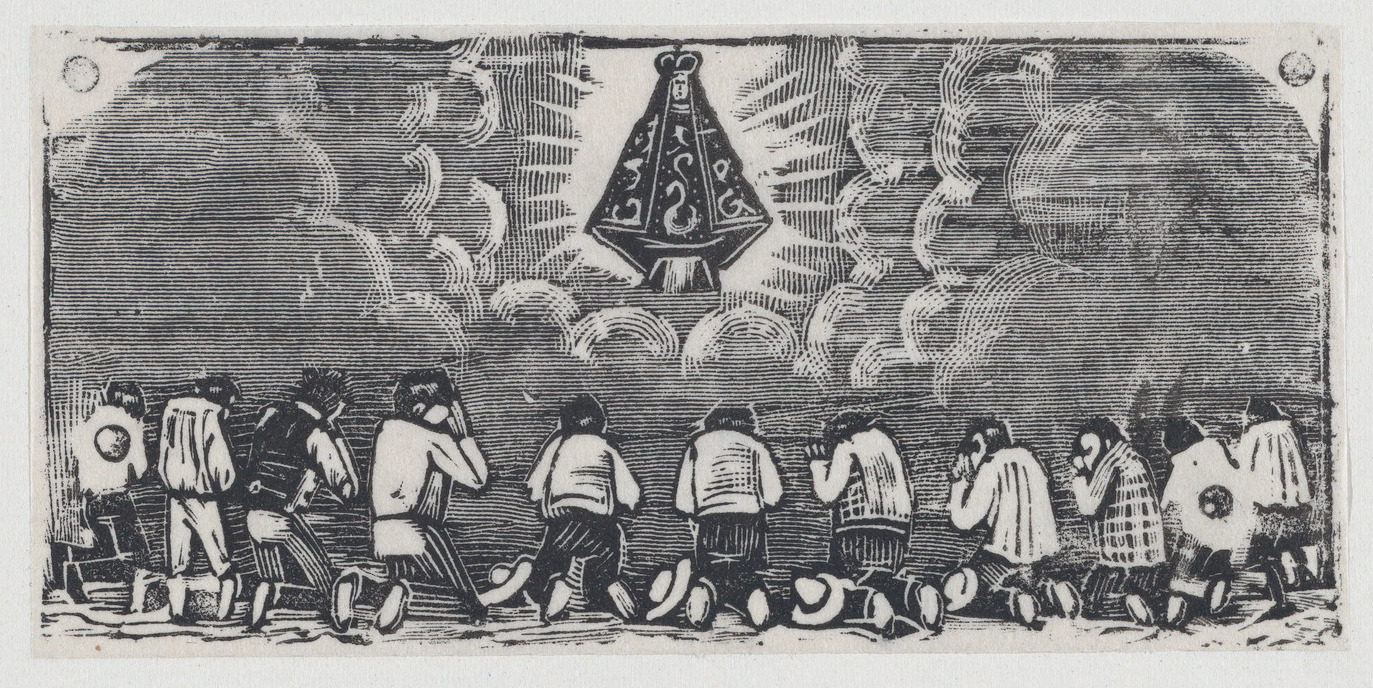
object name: print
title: Figures kneeling before the Virgin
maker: josé guadalupe posada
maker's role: artist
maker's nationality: mexican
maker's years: 1852-1913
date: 1900-1910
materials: metal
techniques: engraving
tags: men,virgin mary